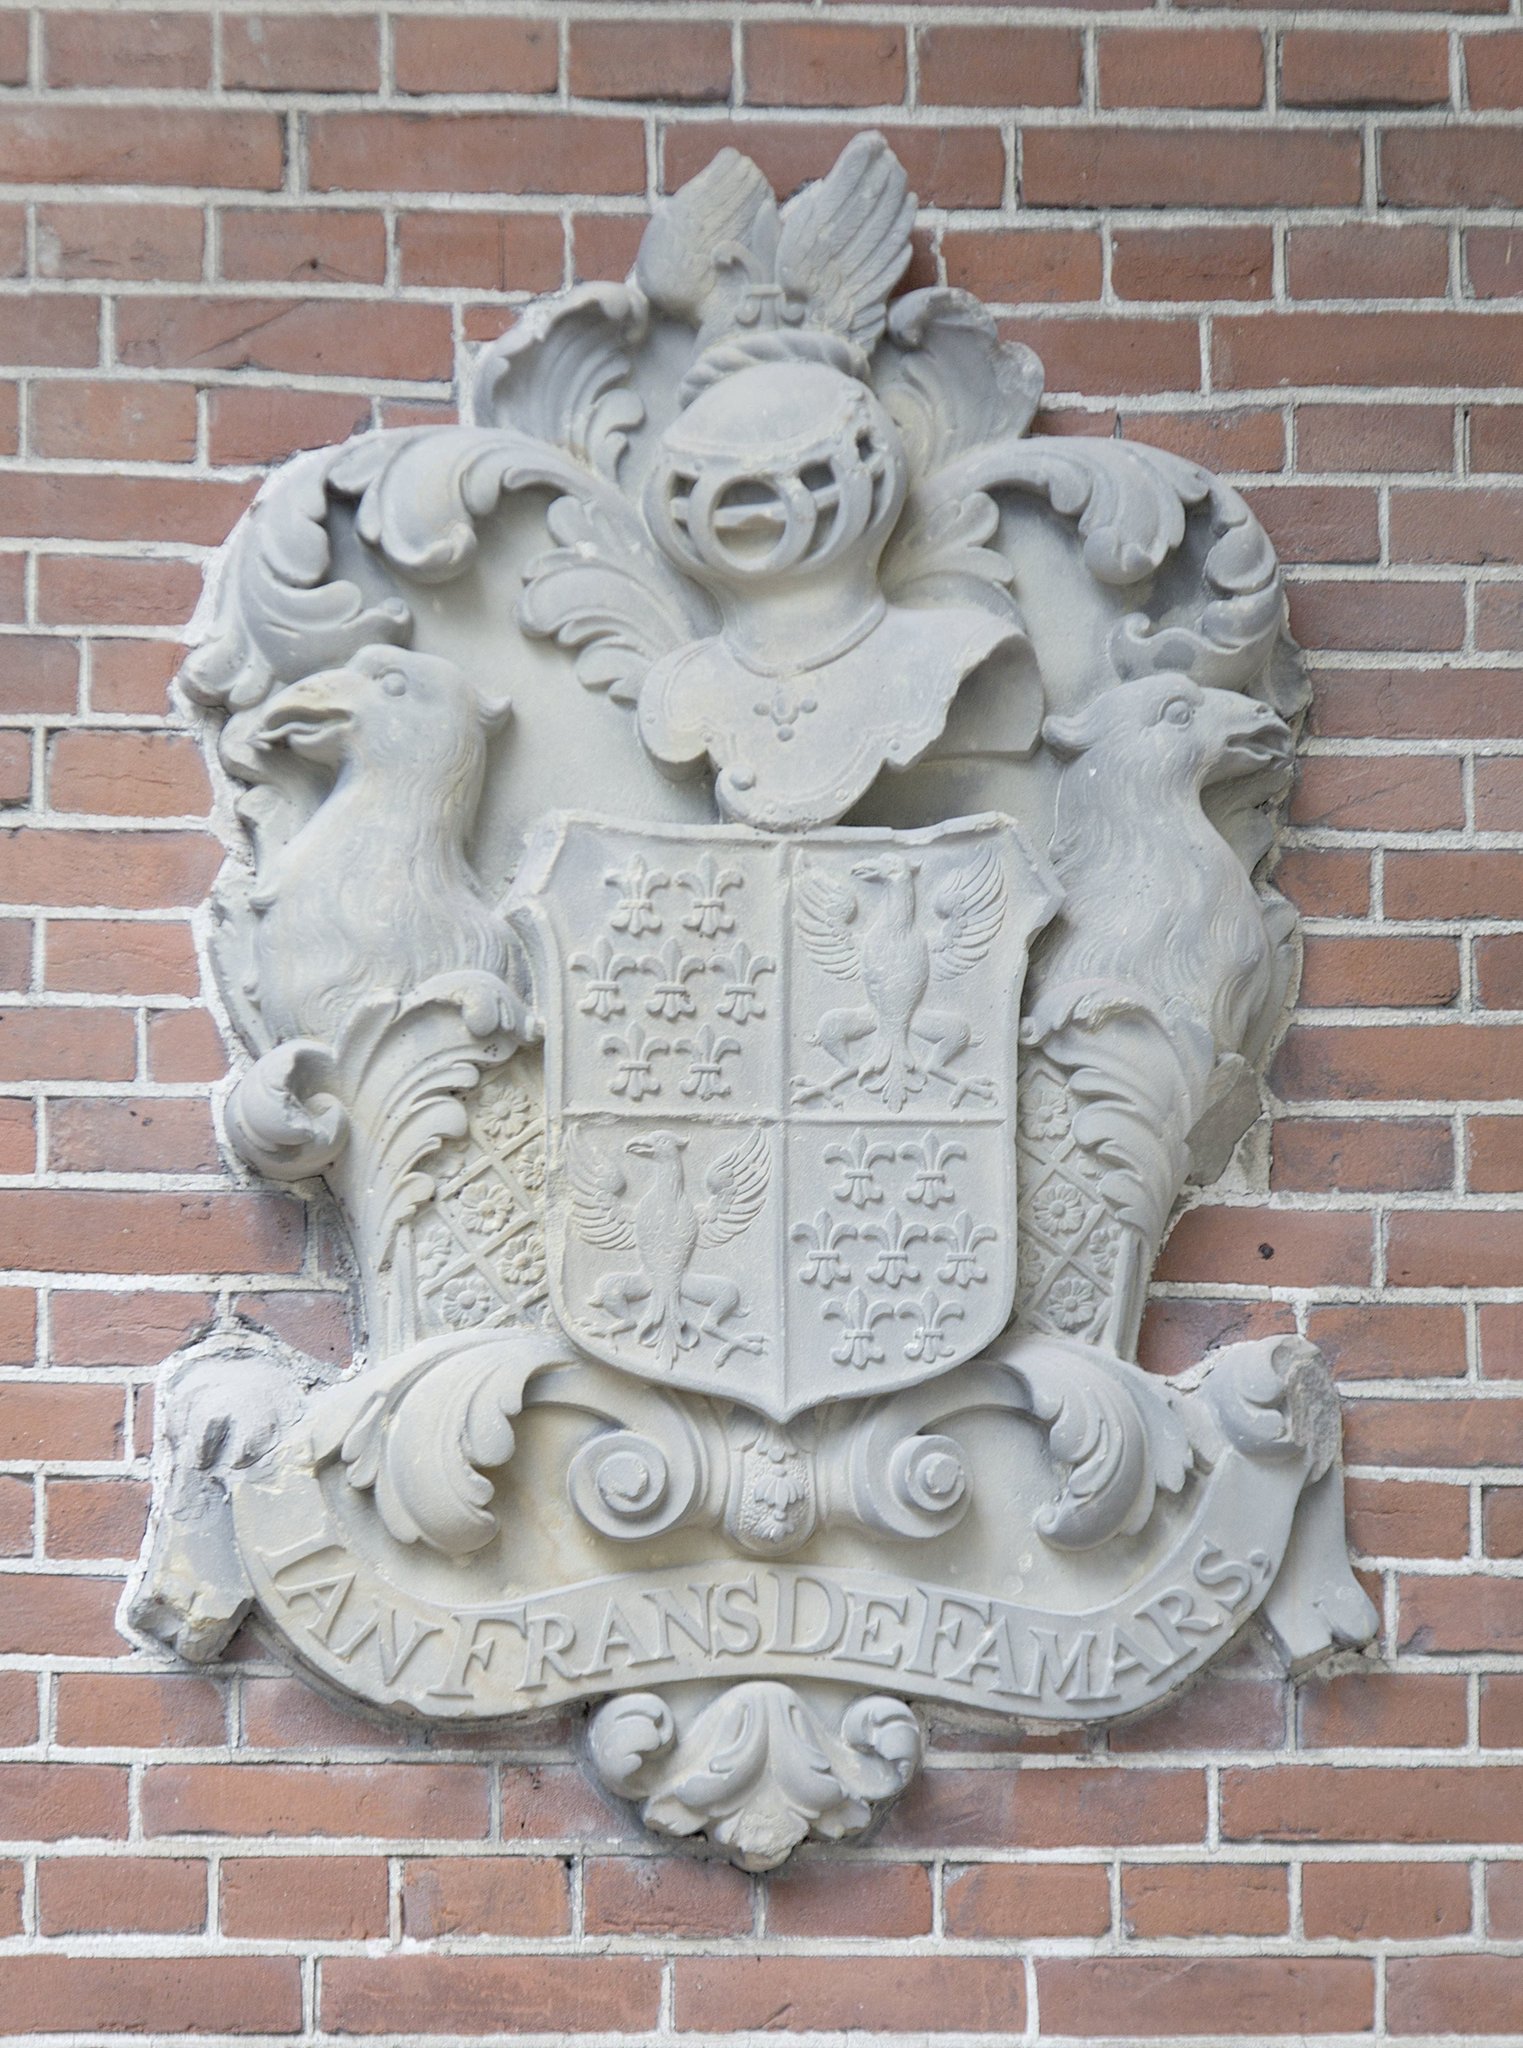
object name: gable stone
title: Gevelsteen met het wapen van Jan Frans de Famars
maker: Anonymous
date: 1735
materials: stone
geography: netherlands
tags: jan frans de famars, leprozenhuis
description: Gevelsteen met het wapen van Jan Frans de Famart. Afkomstig van het Leprozenhuis te Amsterdam.